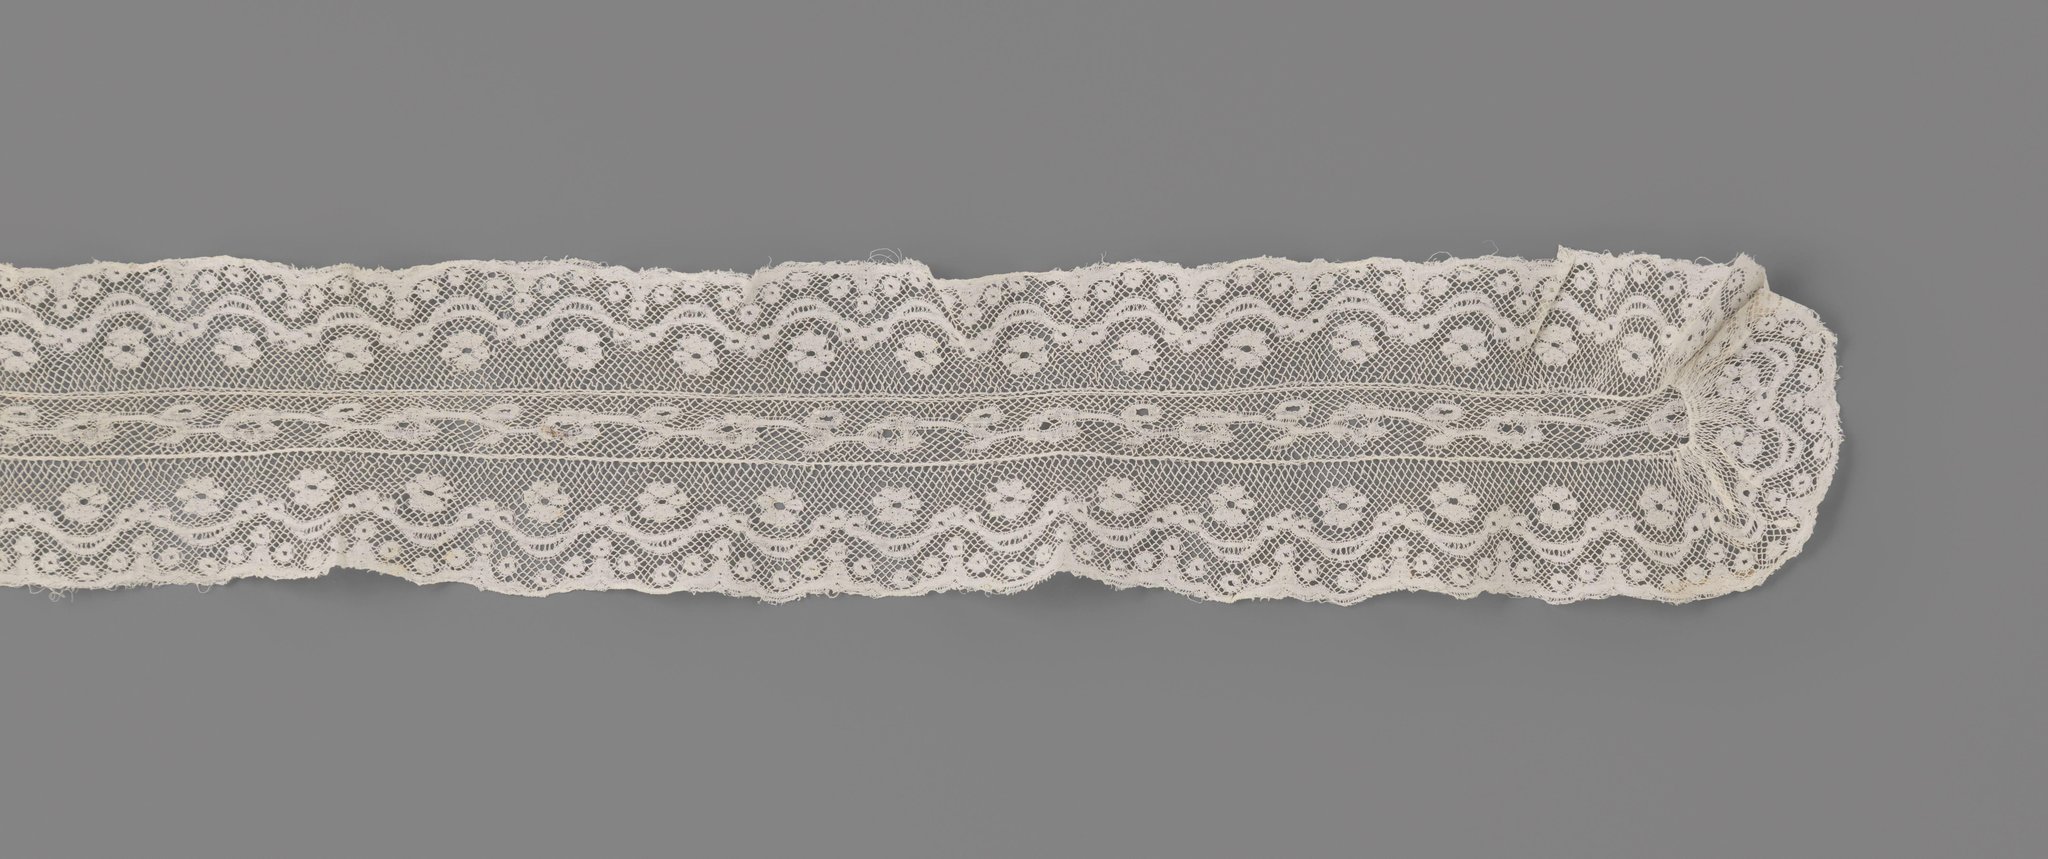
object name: womenswear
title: Das van Valenciennes-kant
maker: Anonymous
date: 1880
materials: lace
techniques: lace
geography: western europe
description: Das van Valenciennes-kant, gemaakt van een tussenzetsel met doorlopende slingerende tak met bladeren en bloemen met daaromheen een glad aangezette licht geschulpte strook met bloemen, een aaneengeschakelde slinger van festoenen en moesjes.